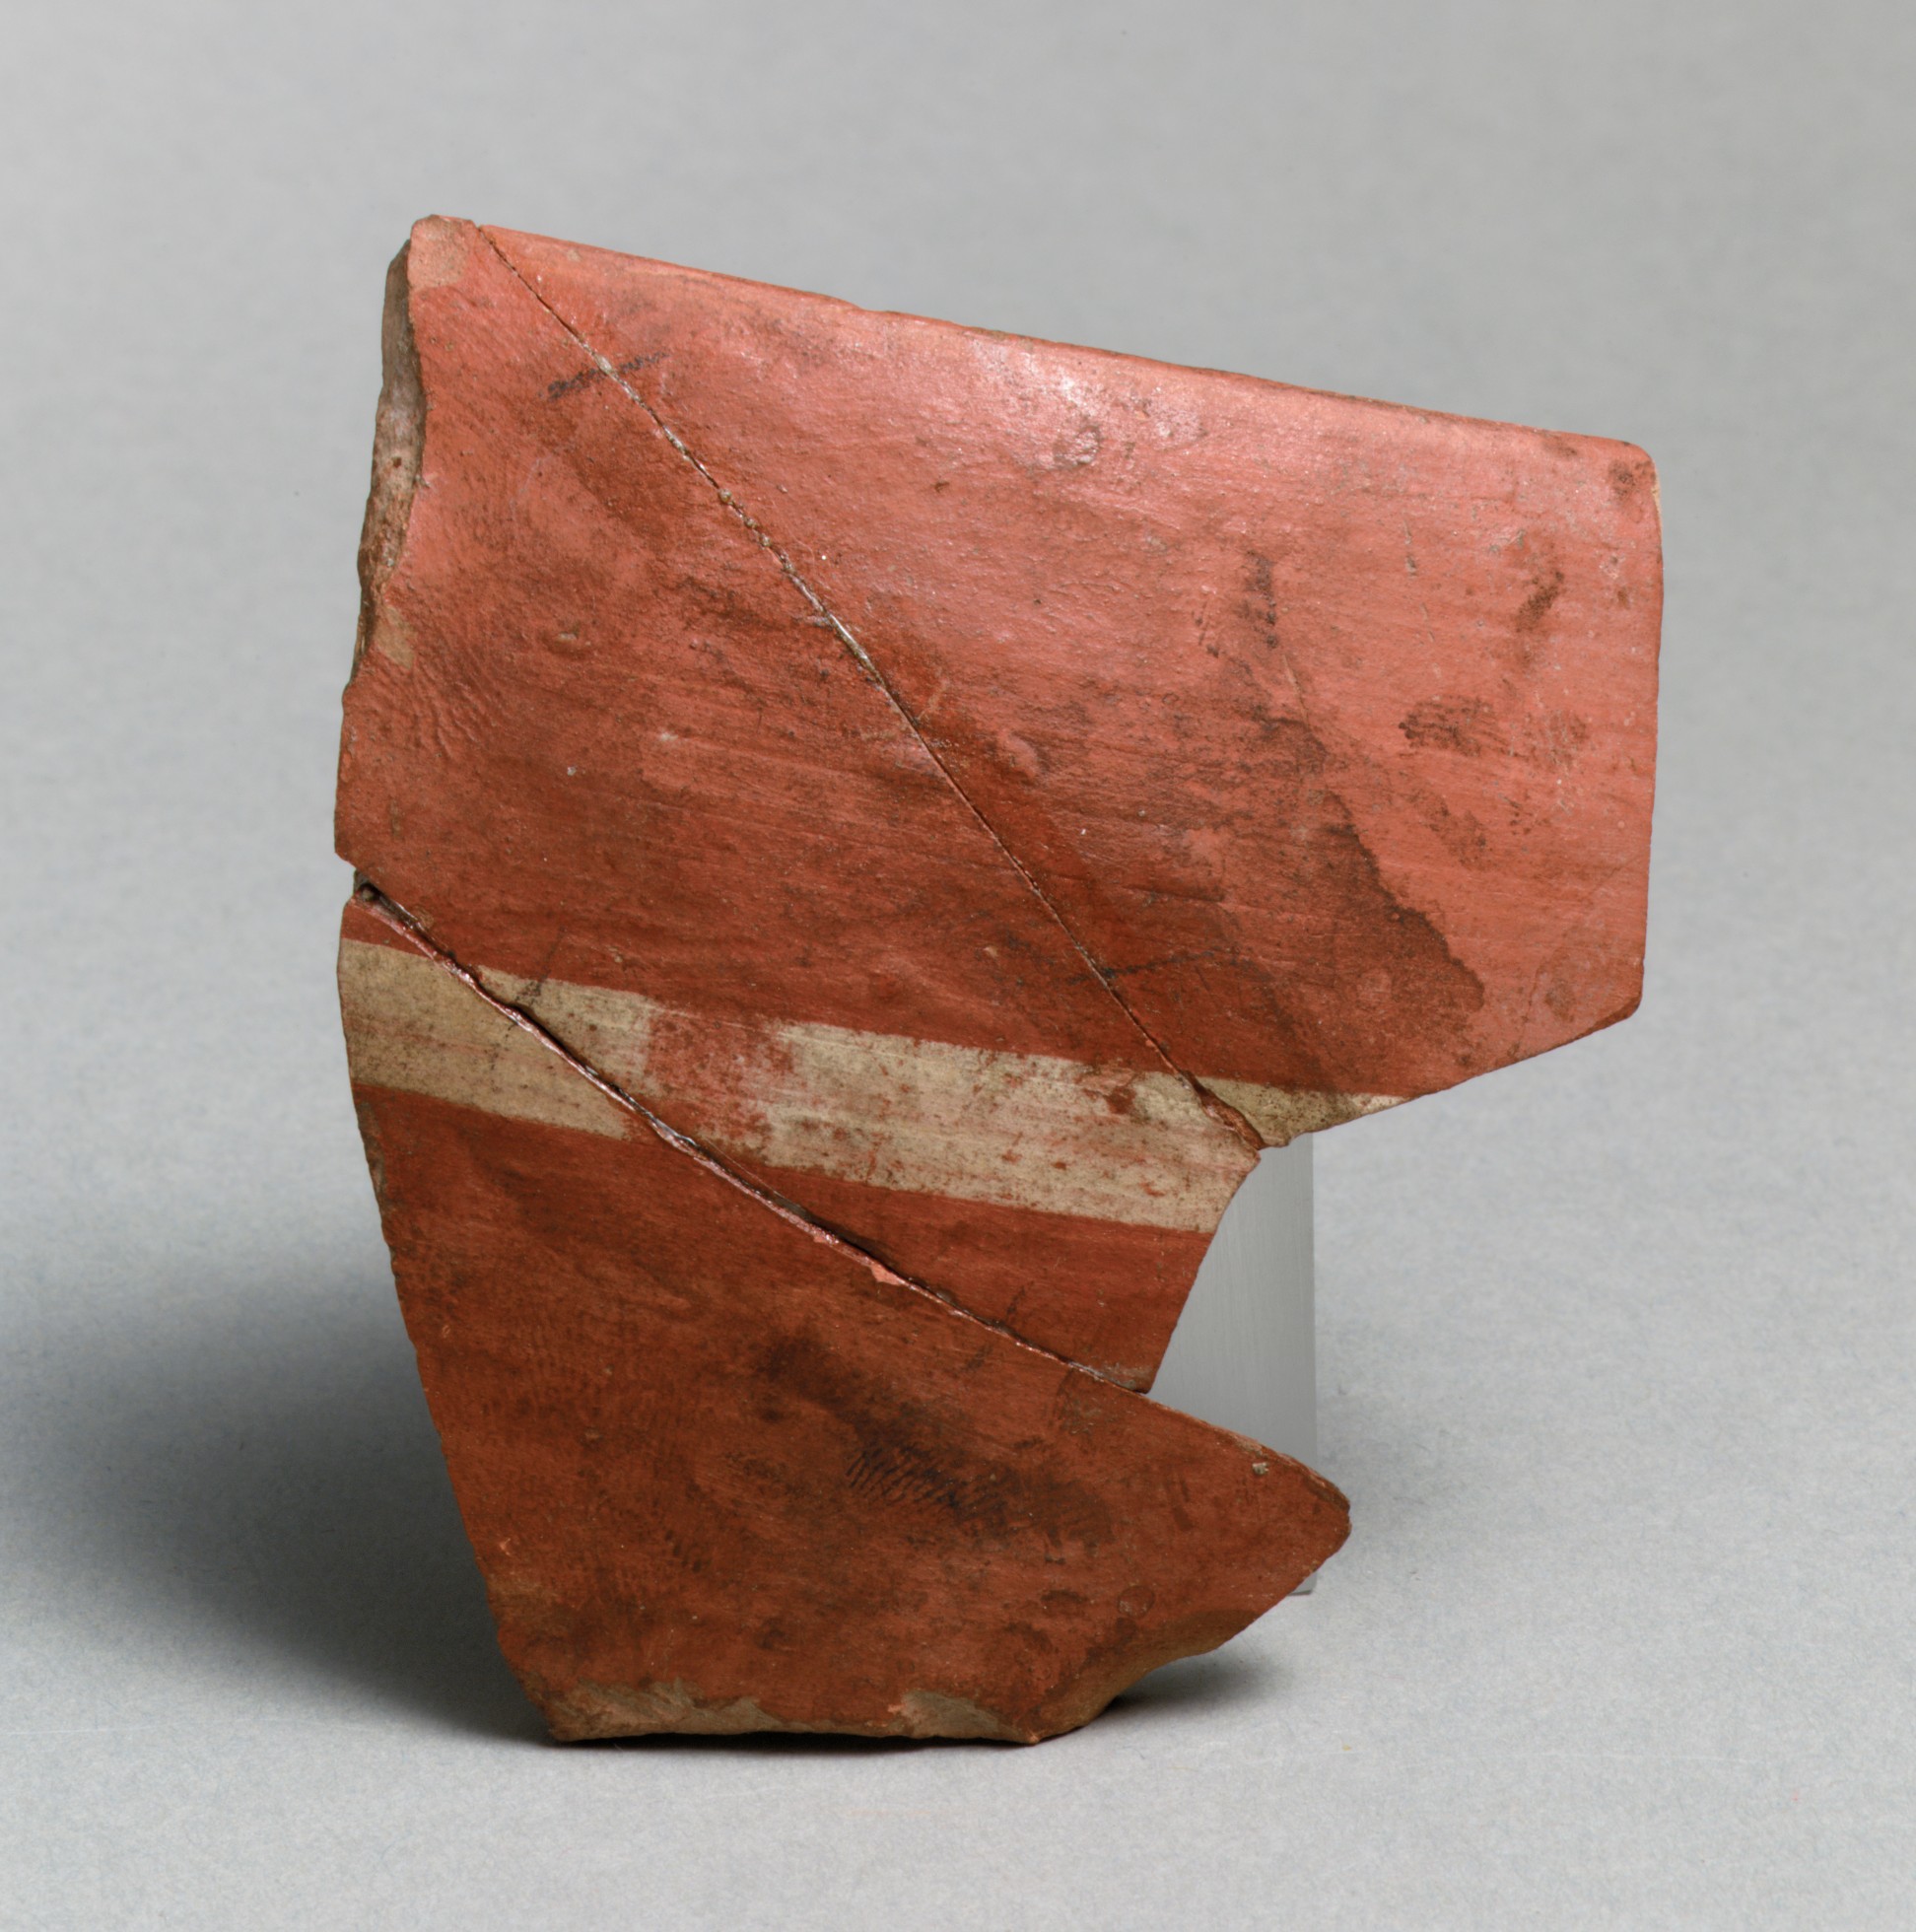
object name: vase fragment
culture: greek or lydian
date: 900-30 BCE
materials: terracotta